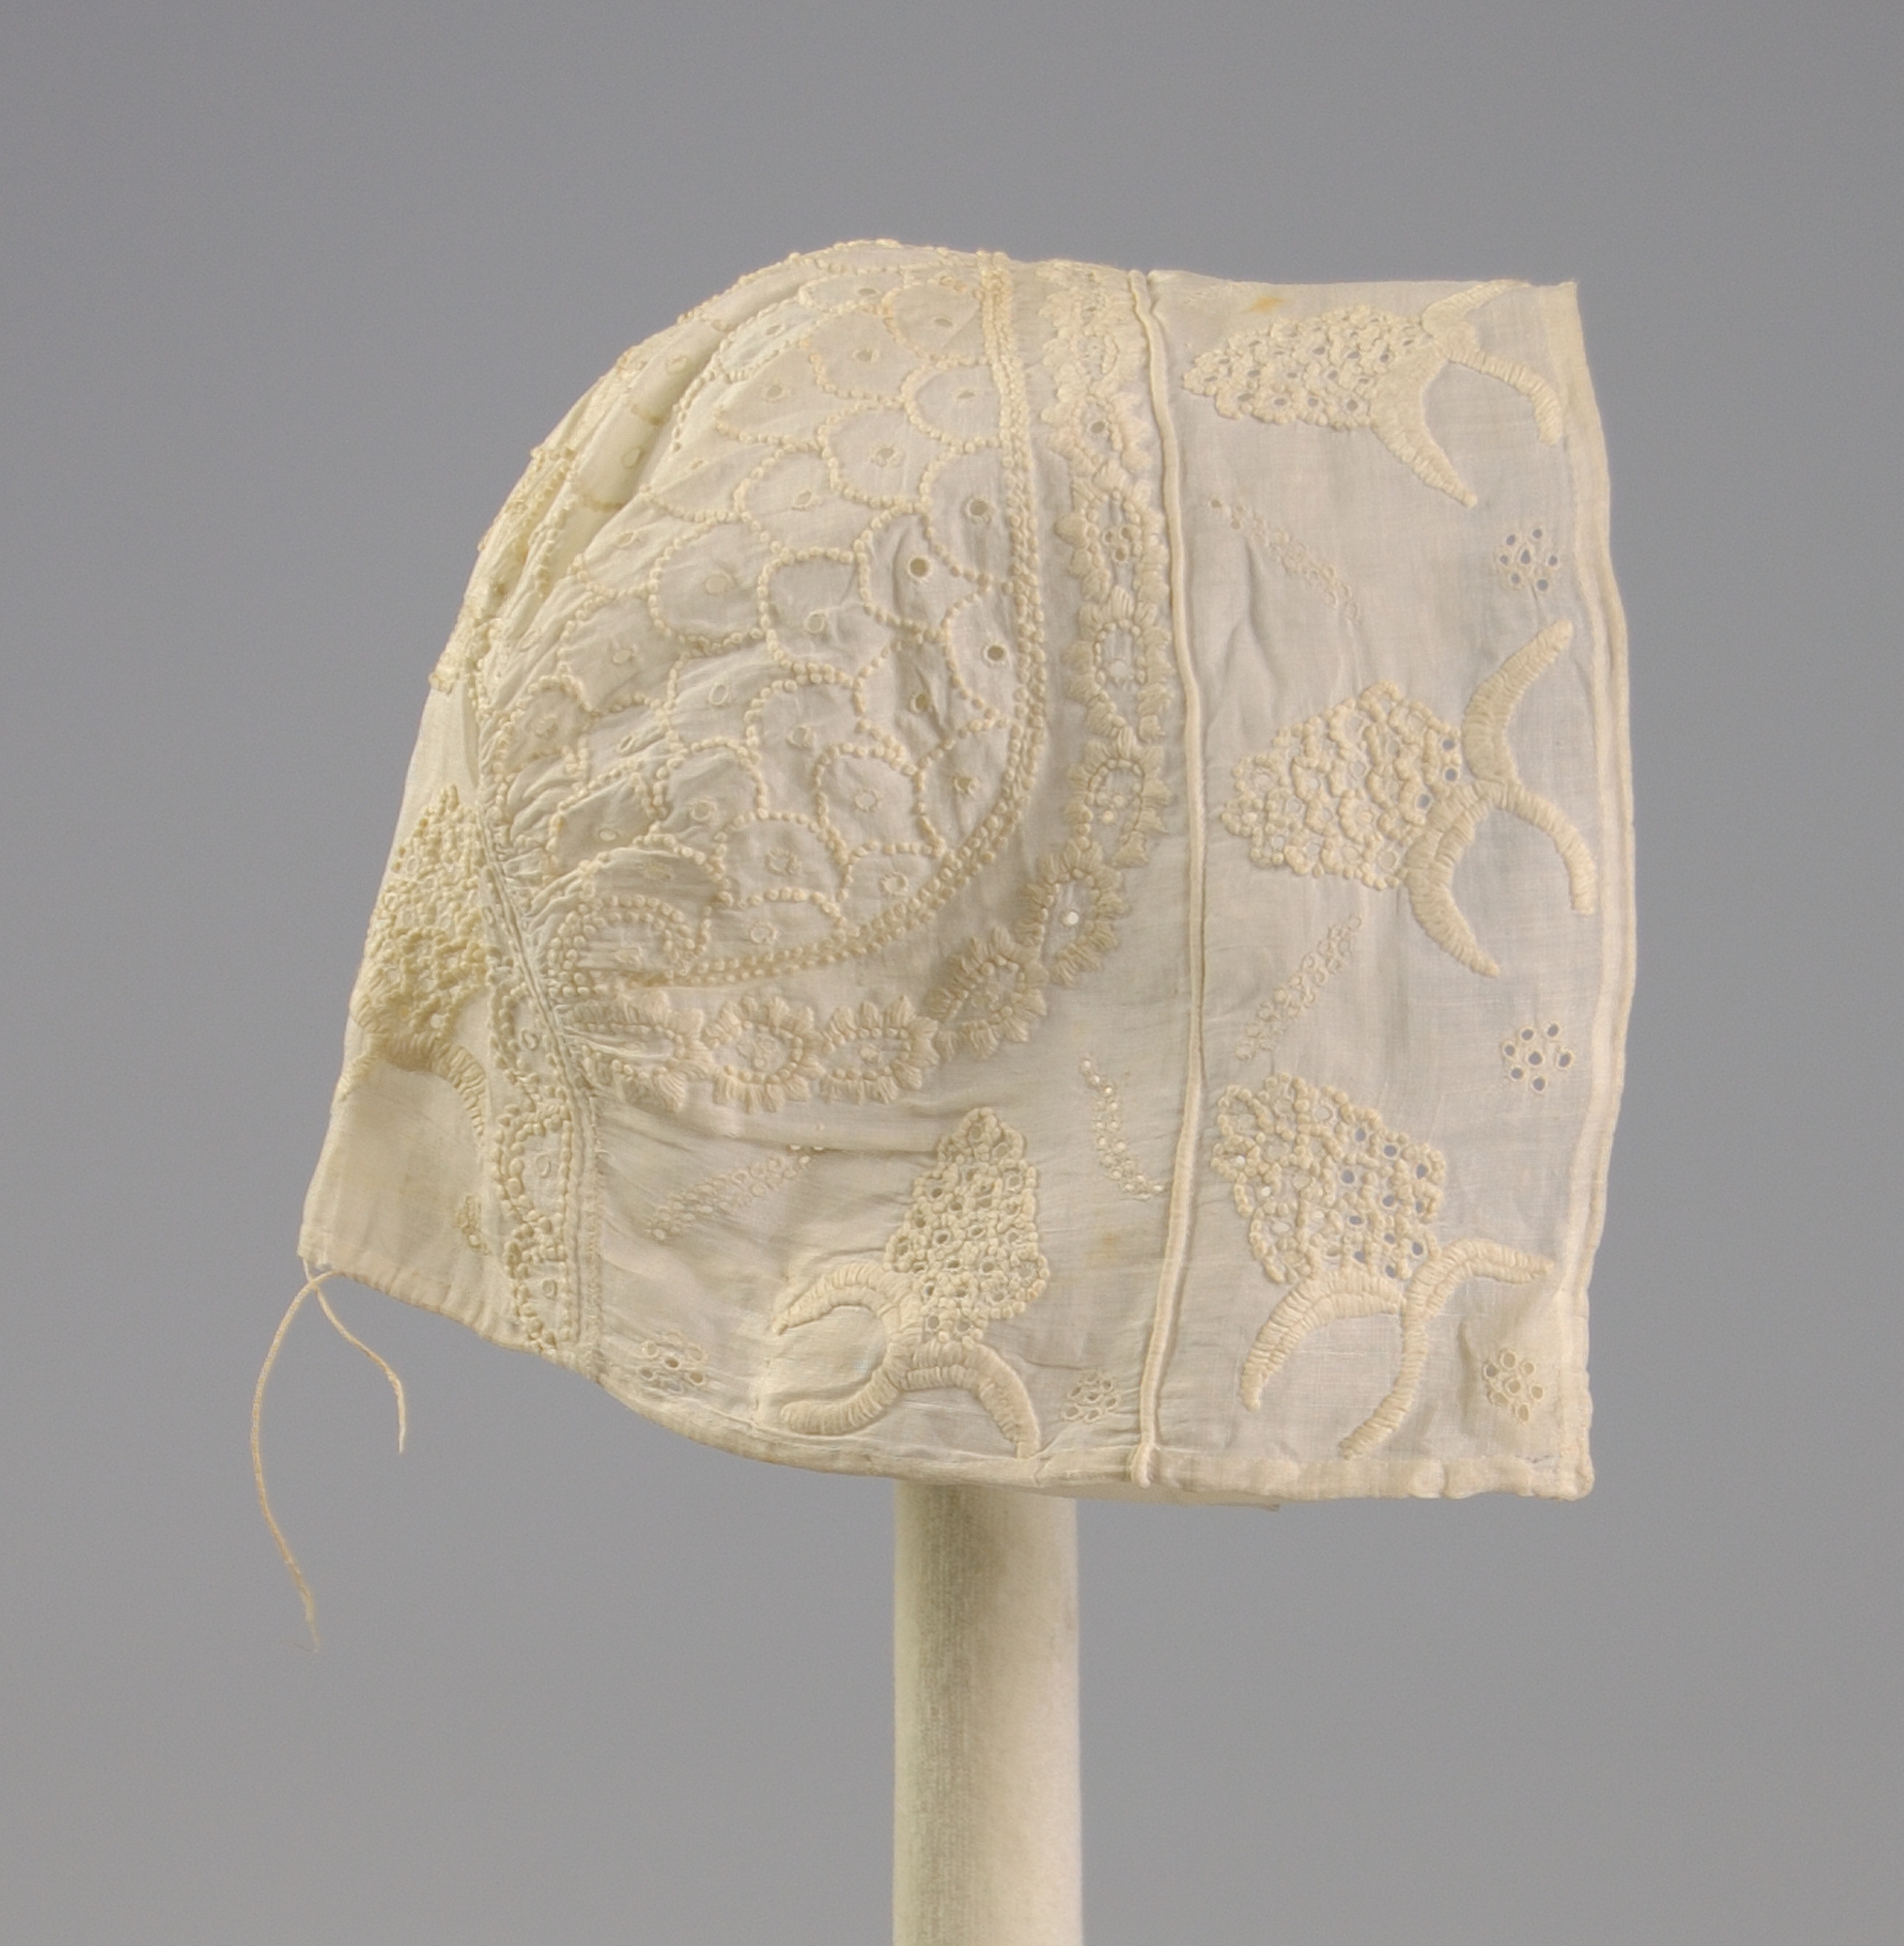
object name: cap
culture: american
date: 1830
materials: cotton